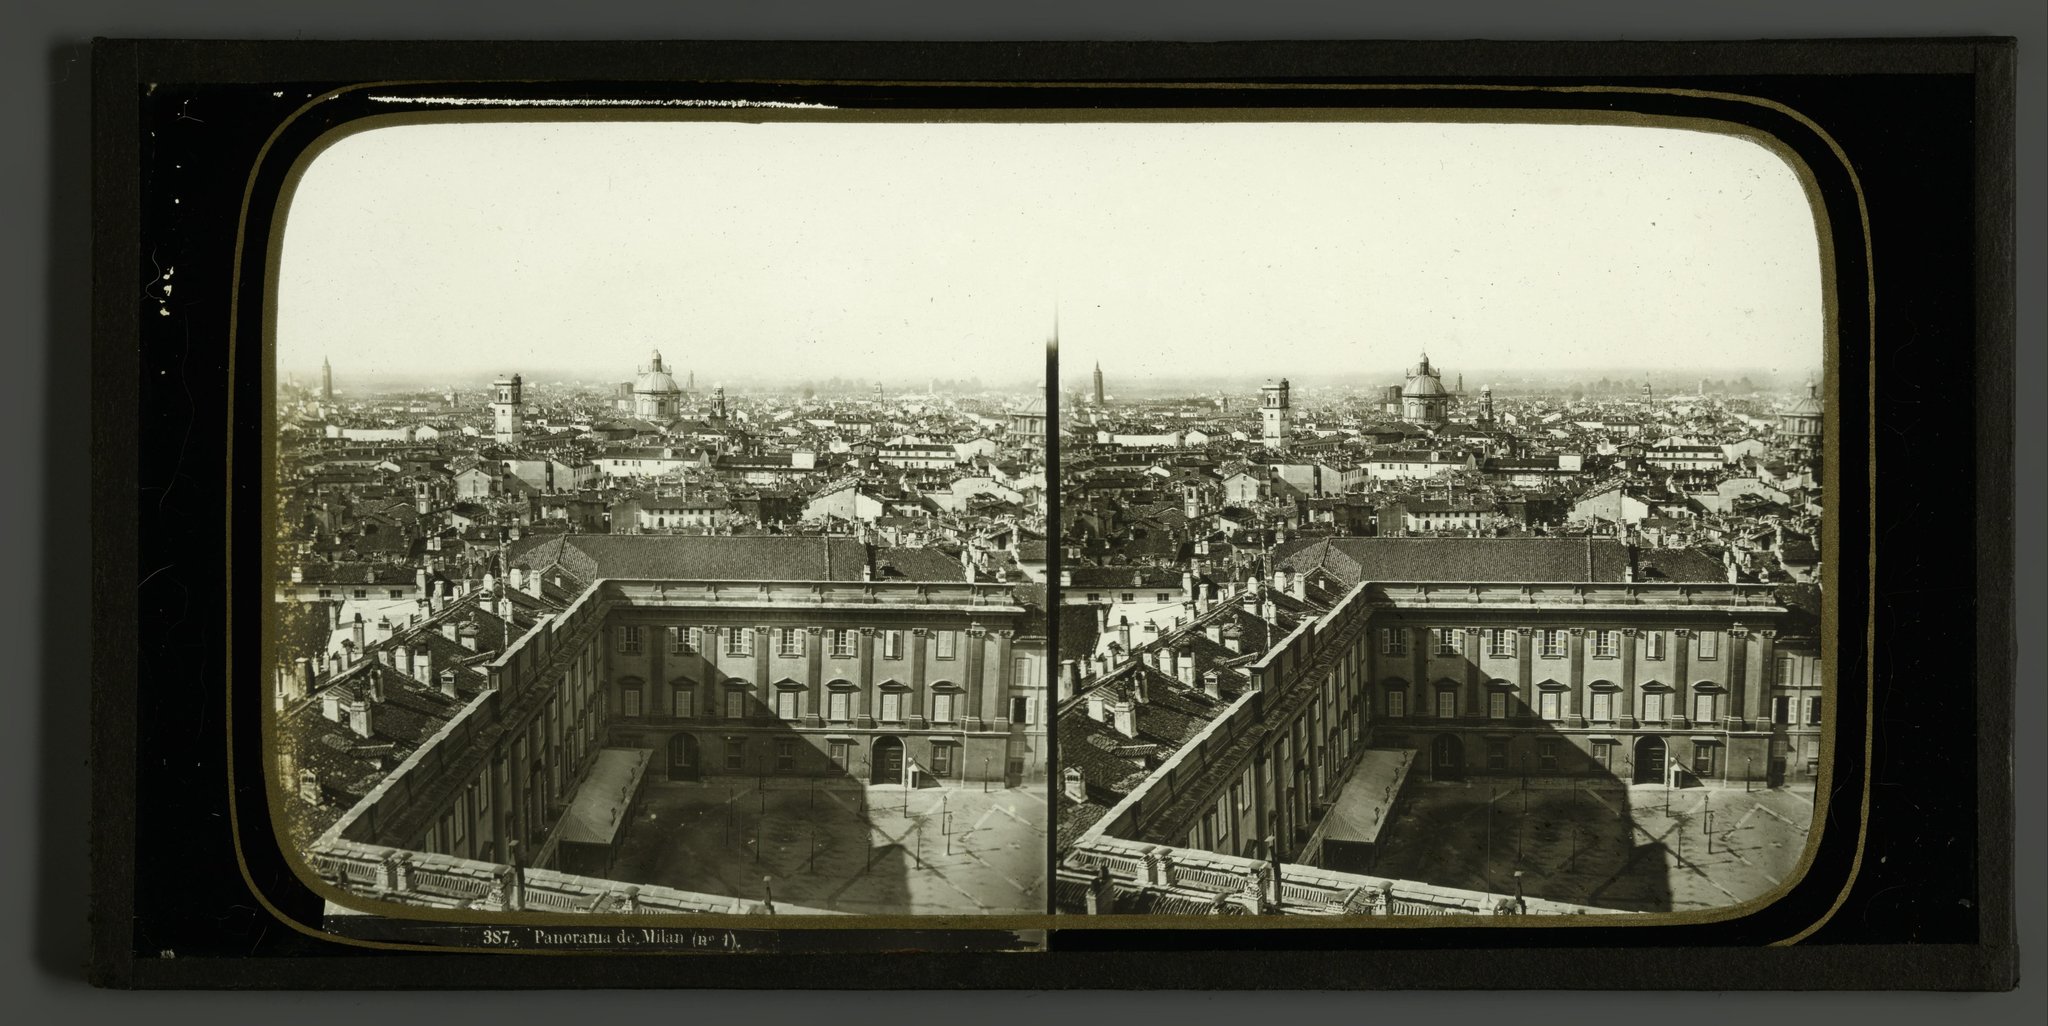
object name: stereoscopic photograph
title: Gezicht op Milaan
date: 1860-1870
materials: glass, paper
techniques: slide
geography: milan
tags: city-view in general; 'veduta'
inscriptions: inscription: ‘Panorama de Milan (No 1)’